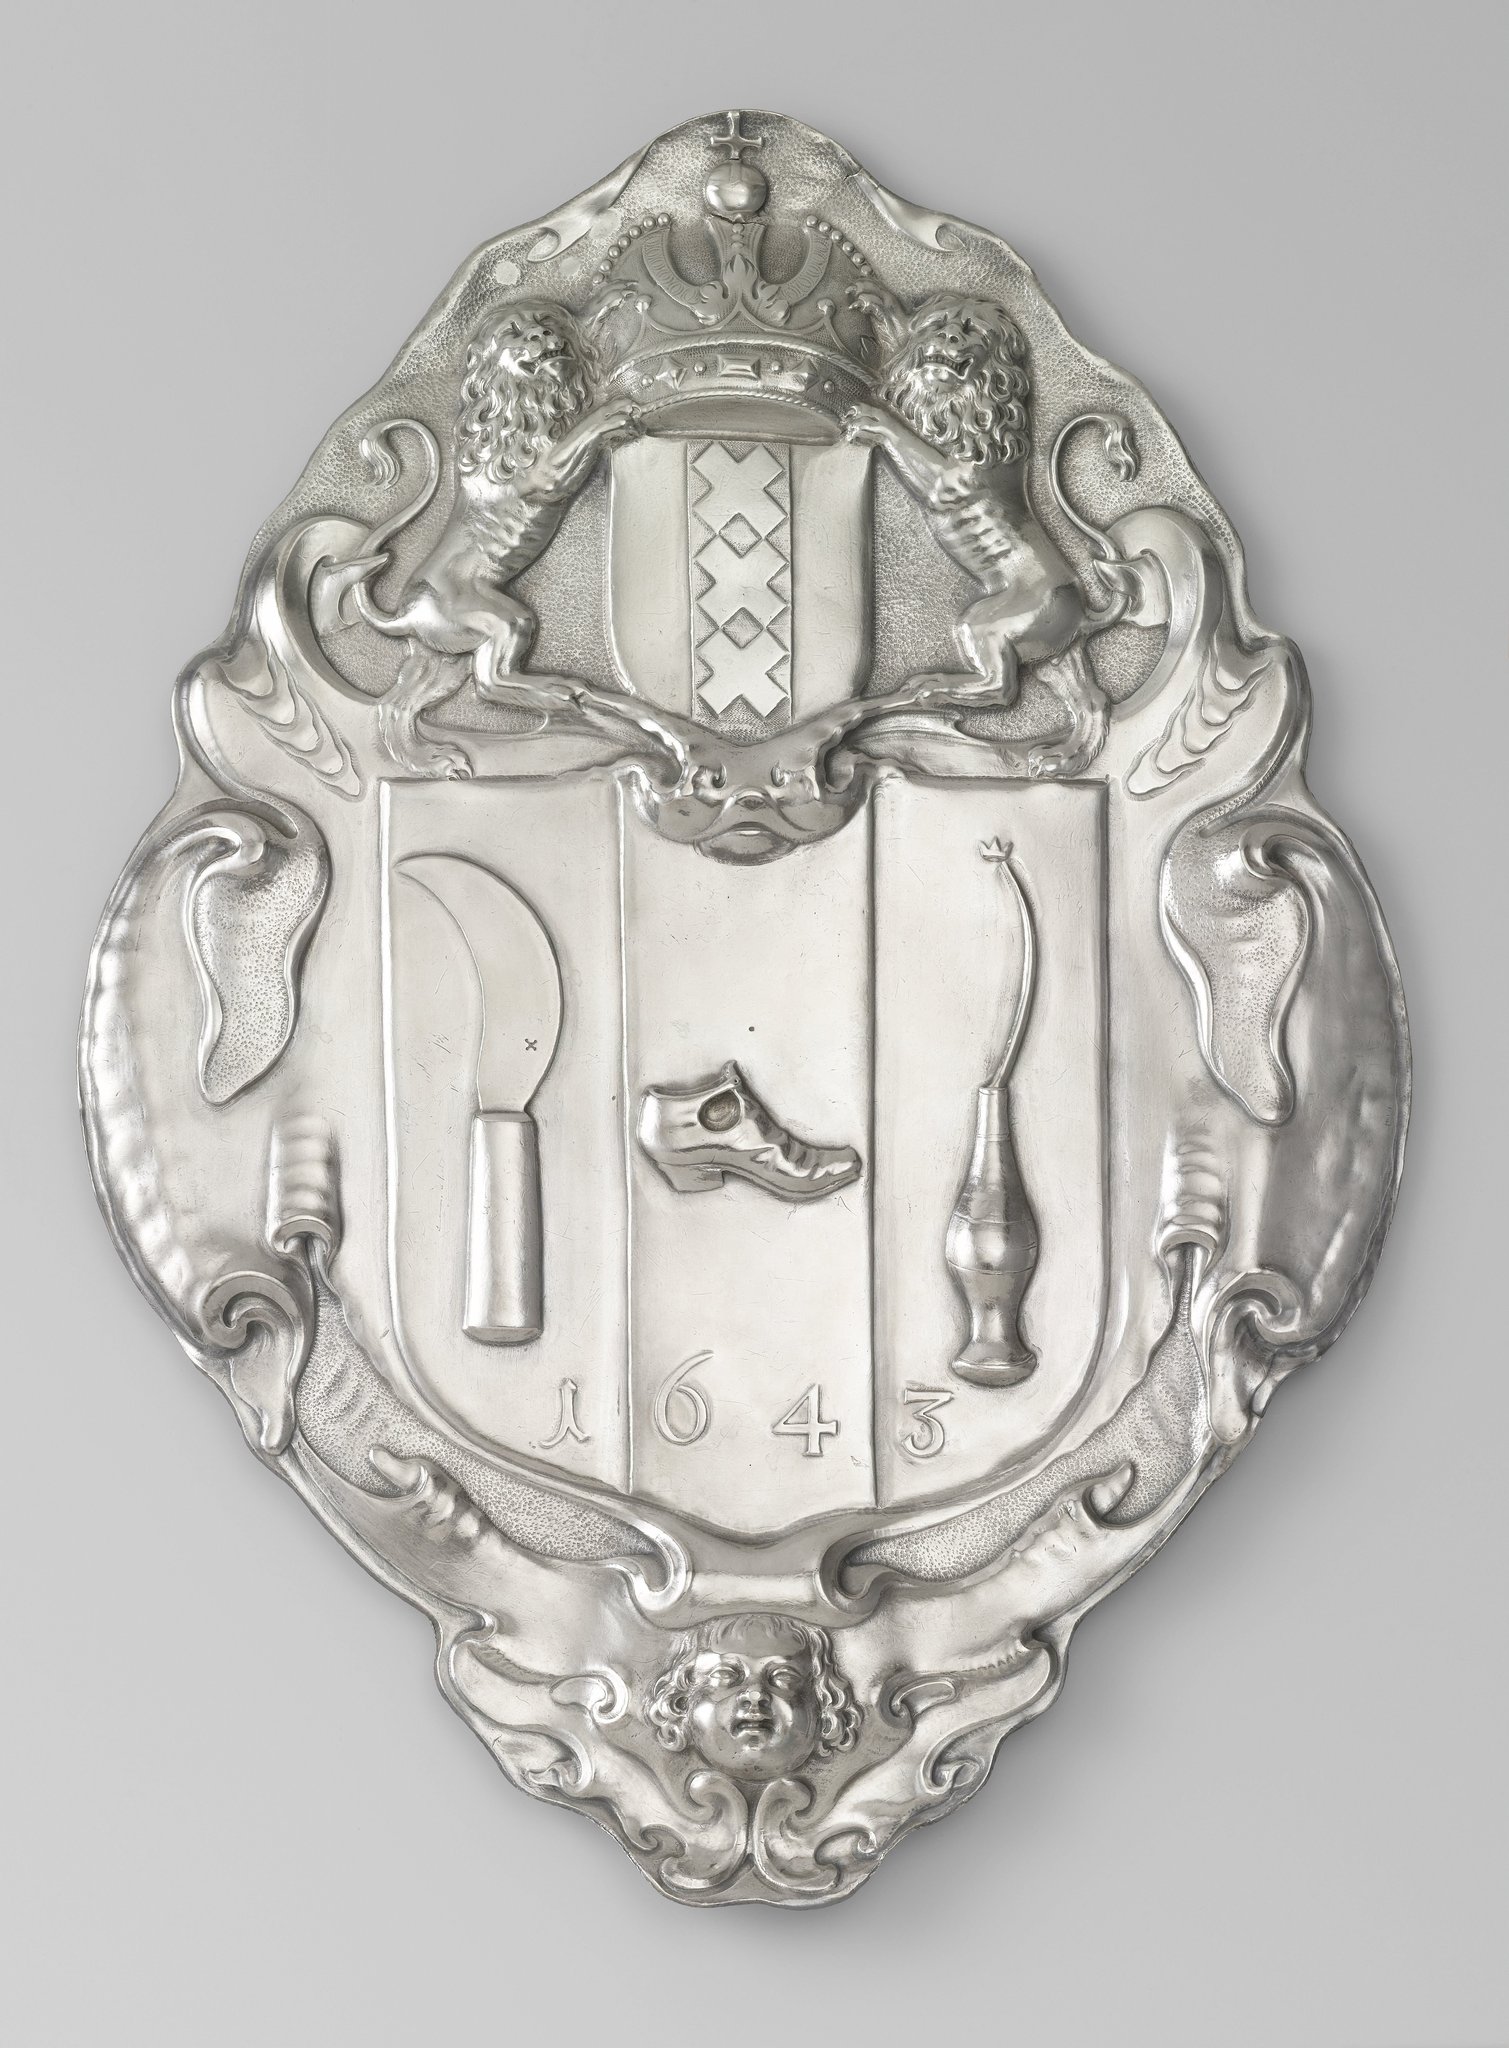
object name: begrafenisschild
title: Funeral Shield of the Cobblers’ Guild in Amsterdam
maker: johannes grill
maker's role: silversmith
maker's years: 1614-1670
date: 1643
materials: silver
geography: amsterdam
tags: cherubs, i.e. children's heads with wings, auricular ornament, lobe style ~ ornament, shoe-maker, cobbler, amsterdam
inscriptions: town mark, maker's mark, date letter: ‘M’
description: Two funeral shields from the cobblers guild of Amsterdam. Silver. Amsterdam, 1643, by Johannes Grill. On loan from the city of Amsterdam.